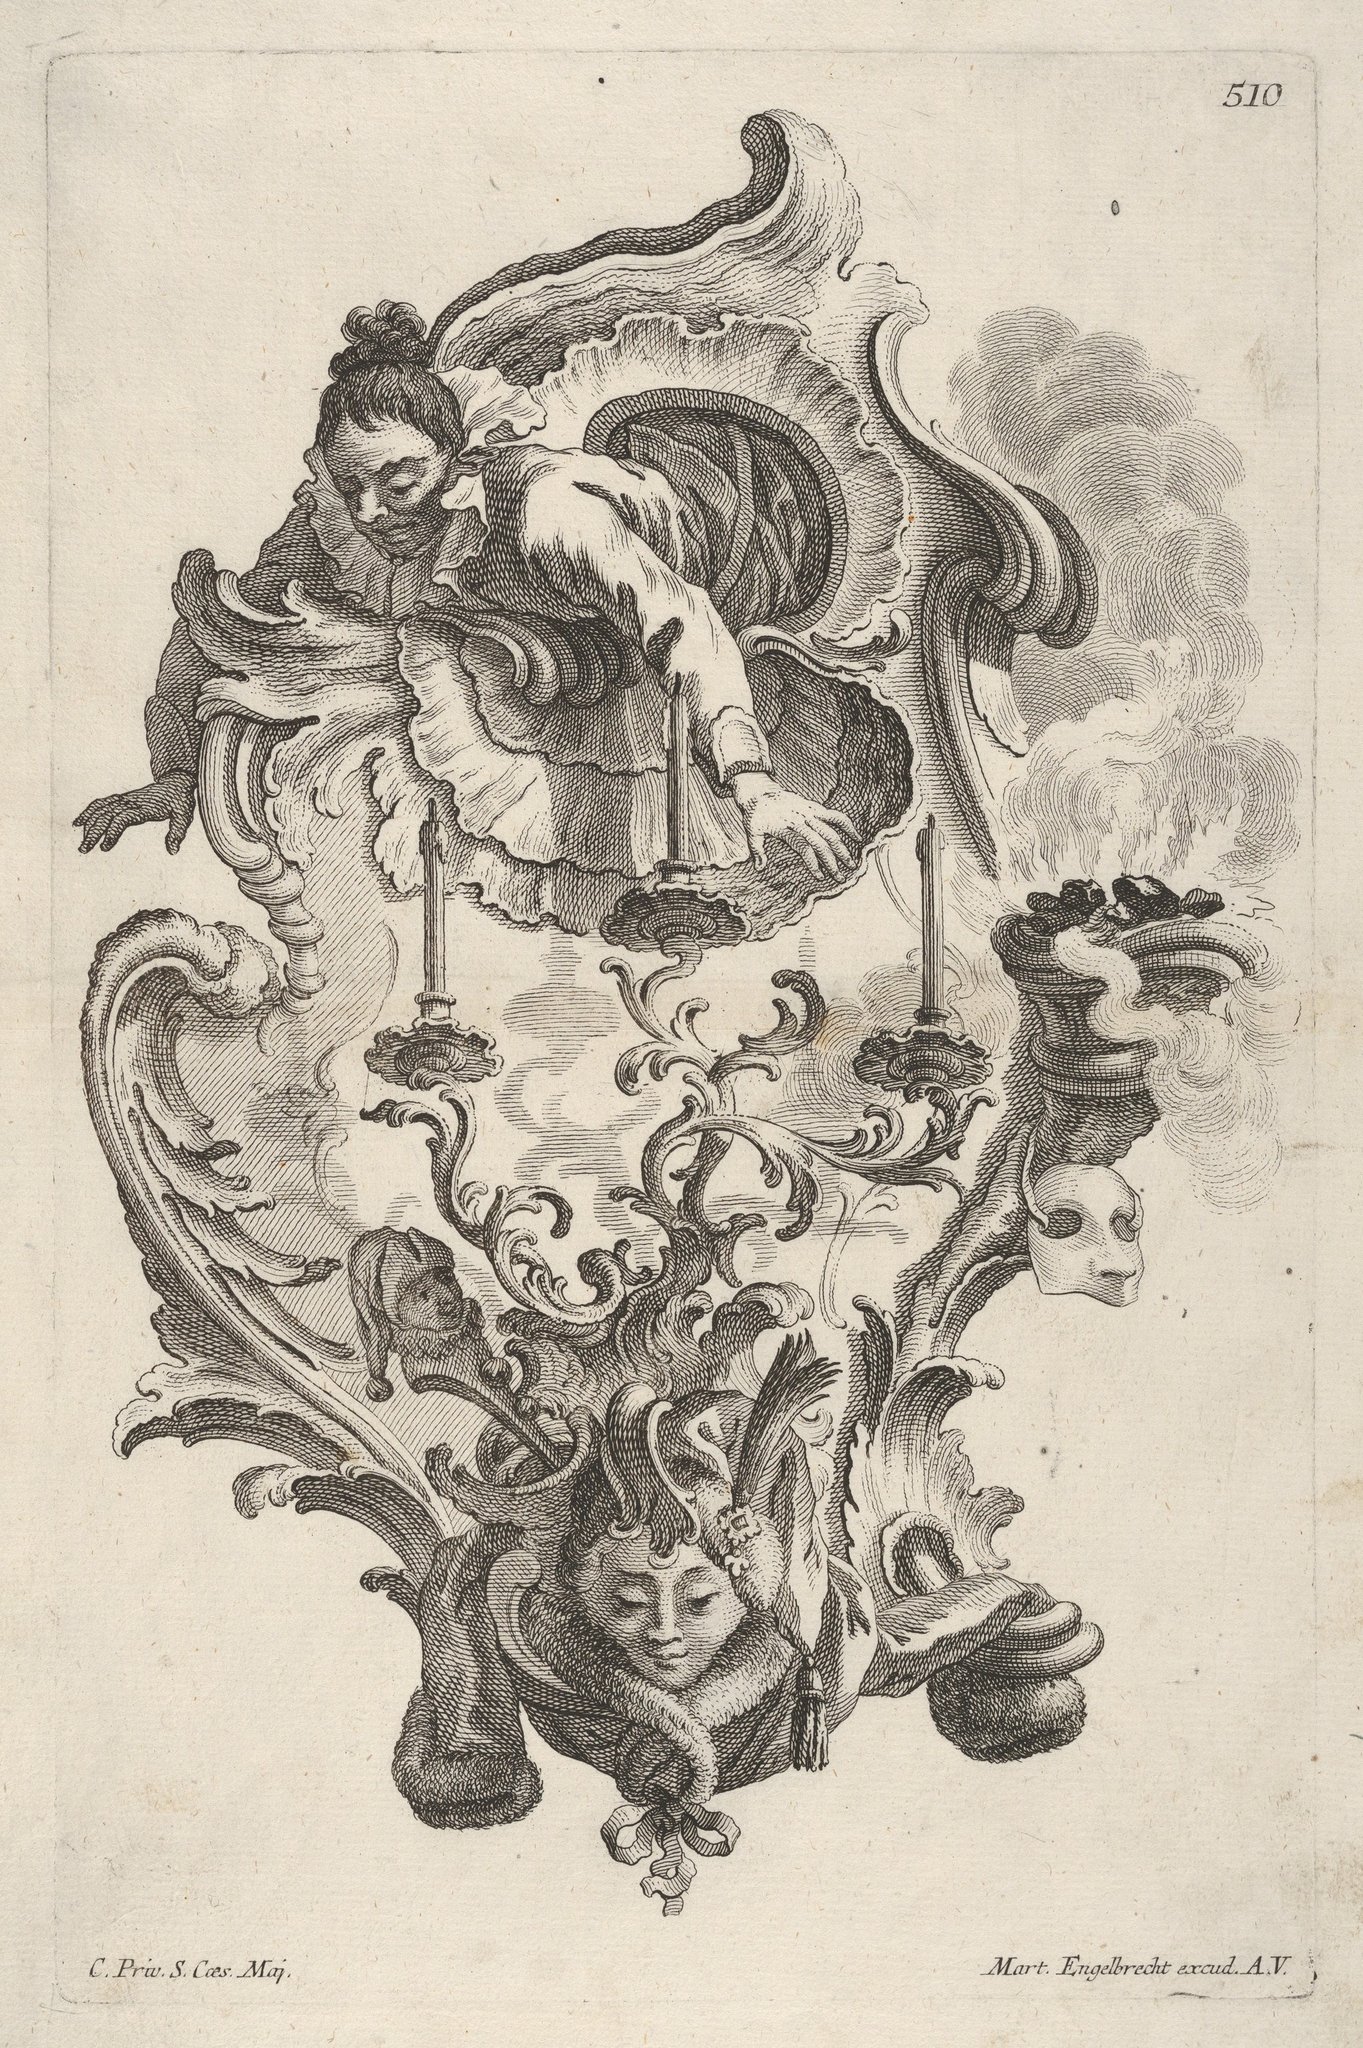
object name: print ornament architecture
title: Sconce Representing Winter, from 'Wand-Leuchter die 4 Jahrseiten vorstellend'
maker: martin engelbrecht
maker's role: publisher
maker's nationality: german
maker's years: 1684-1756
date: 1730-1756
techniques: etching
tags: masks,lighting